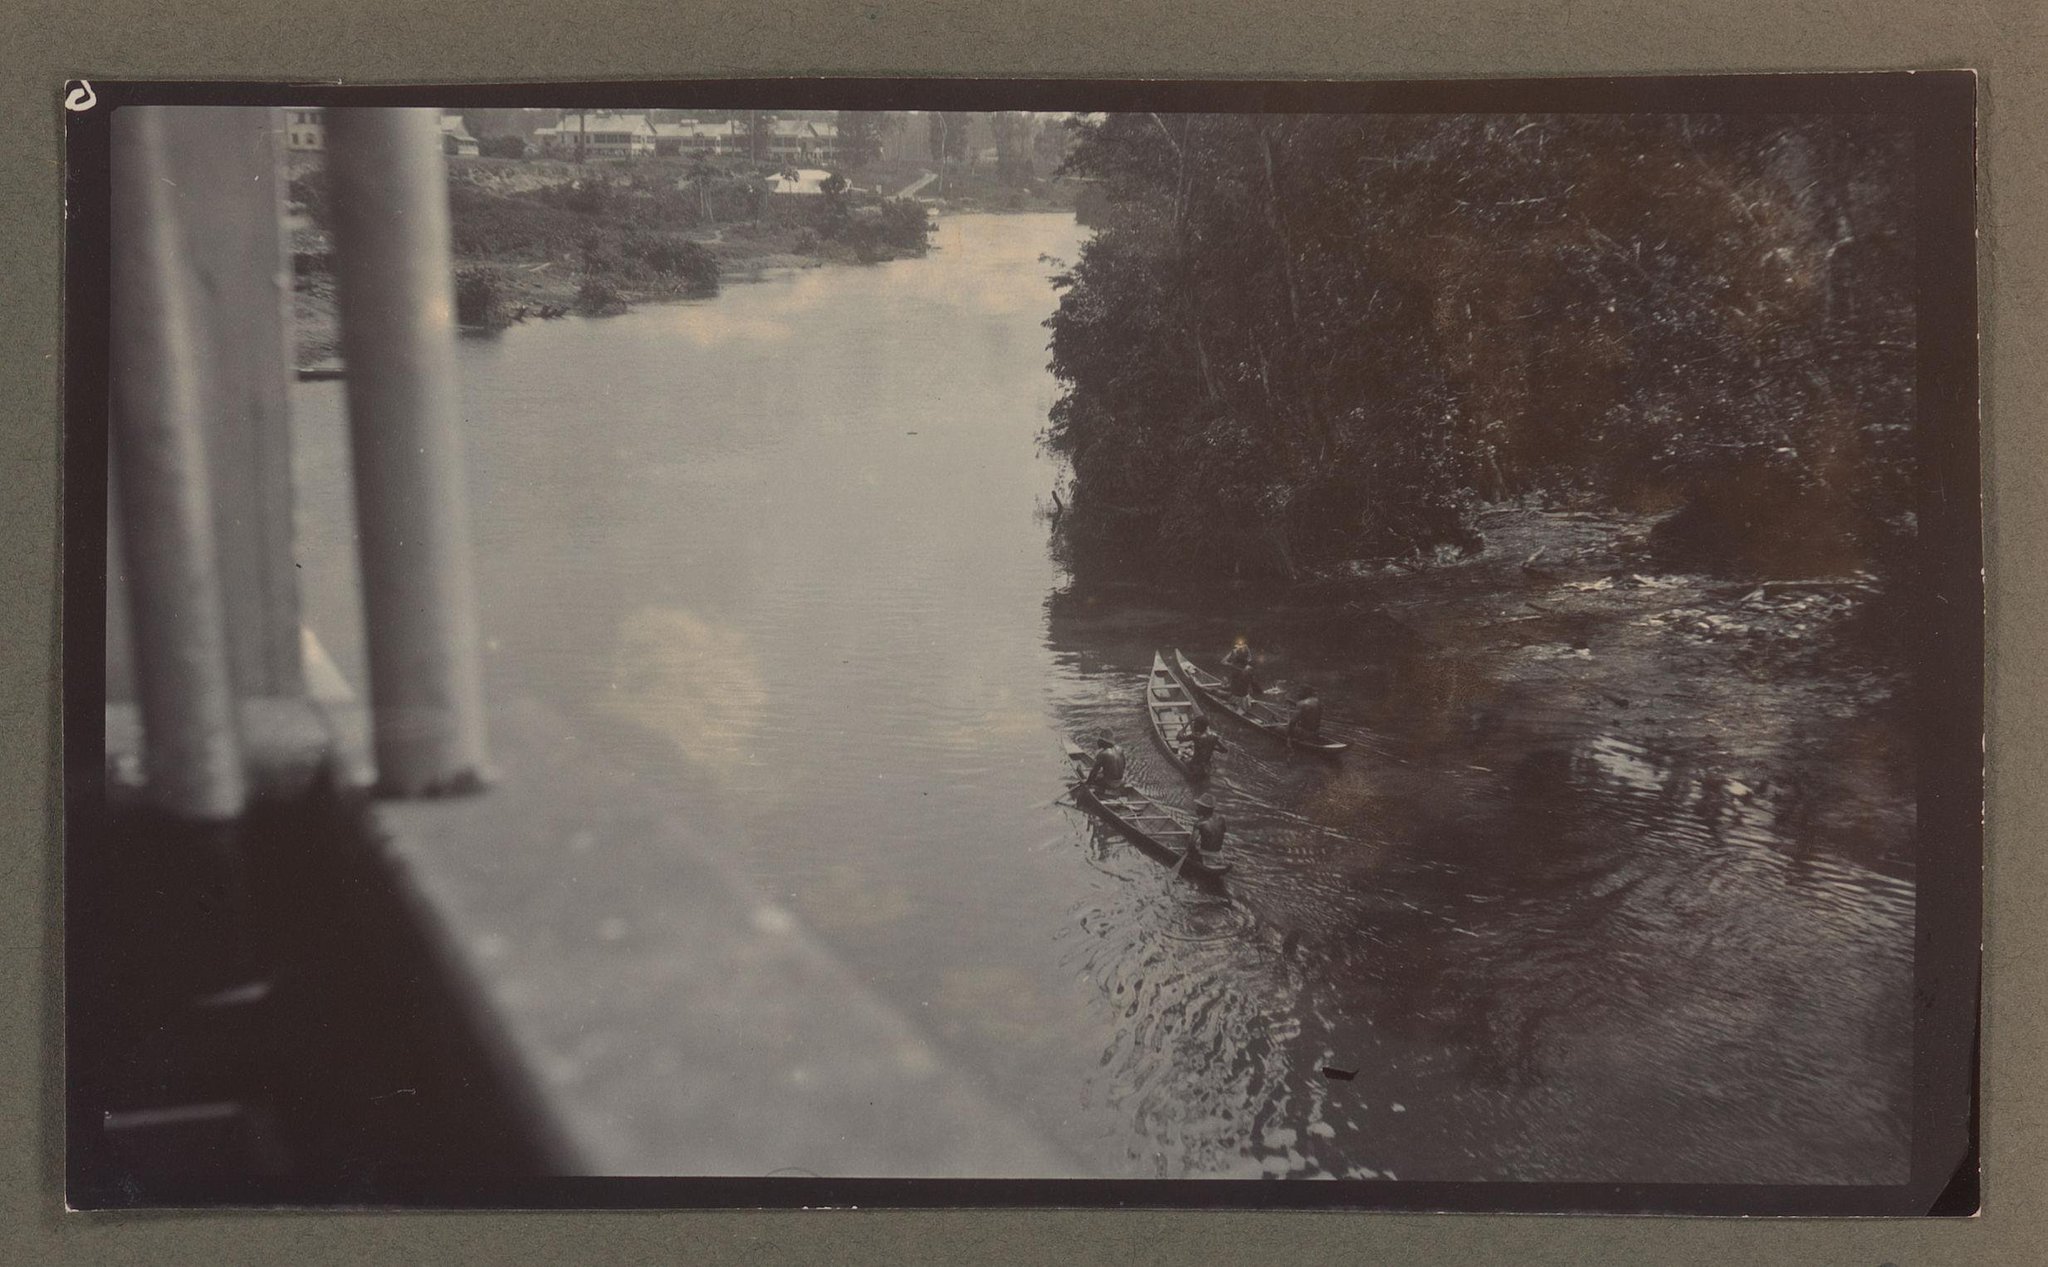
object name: photograph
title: Riviergezicht met bootjes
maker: Anonymous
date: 1925-1927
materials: photographic support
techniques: photography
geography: suriname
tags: jetten, familie, moengo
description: Gezicht vanuit een boot op een rivier met inlanders in bootjes. Foto op een bladzijde van een los albumblad. Onderdeel van het ensemble met foto's van de familie van ingenieur Jetten in de mijnbouwstad Moengo in Suriname.